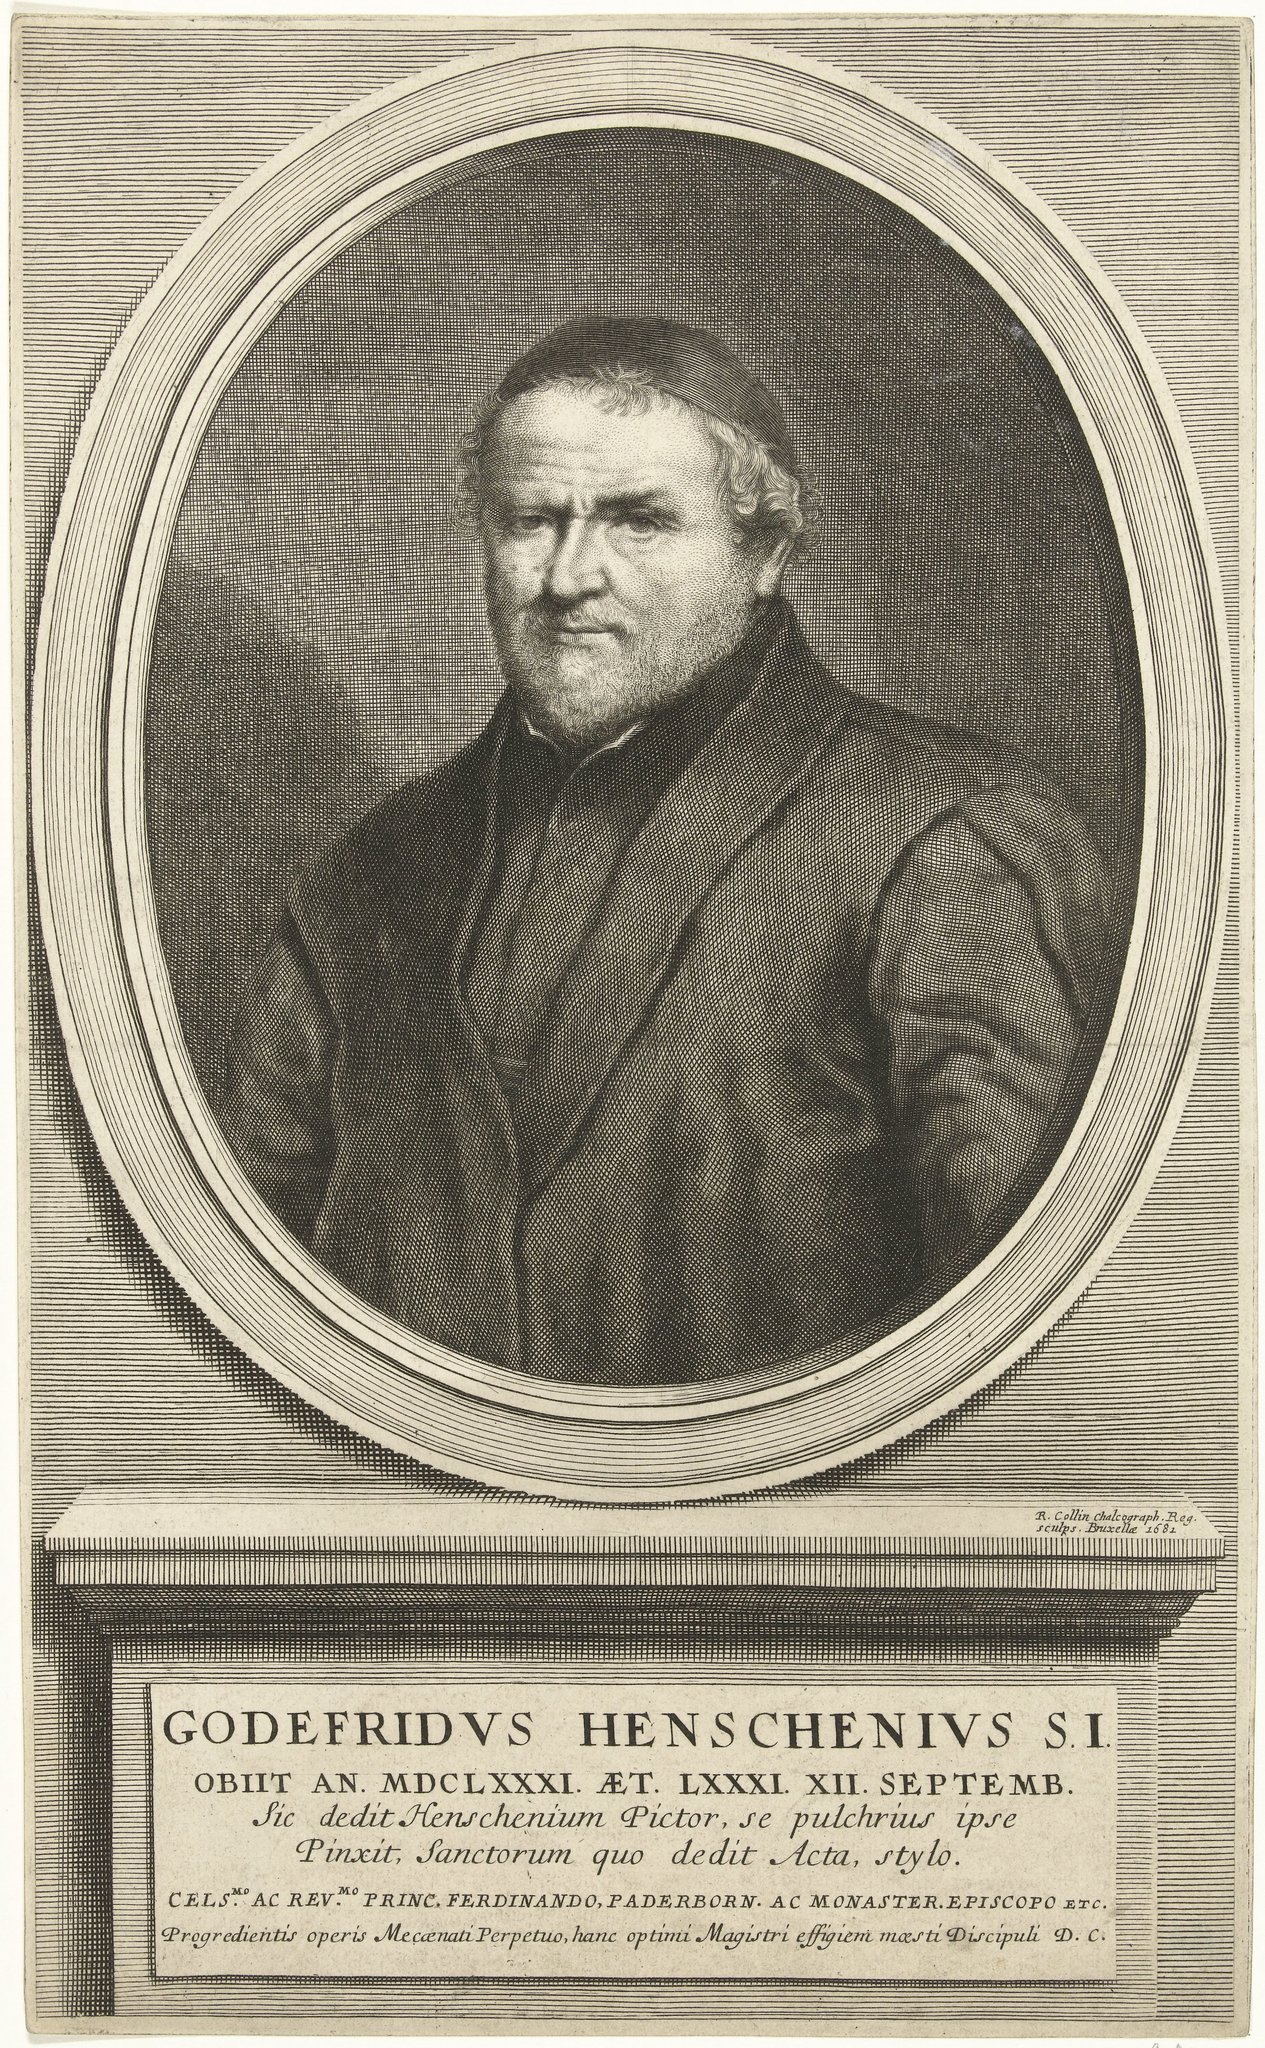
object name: print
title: Portret van Godefridus Henschenius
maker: richard collin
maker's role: print maker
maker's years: 1627-1697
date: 1681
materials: paper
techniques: engraving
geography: brussels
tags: antwerp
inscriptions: collector's mark: Lugt 2228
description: Borstbeeld van de jezuiet Godefridus Henschenius, in ovaal. Onder het portret op de sokkel zijn naam en levensdata.